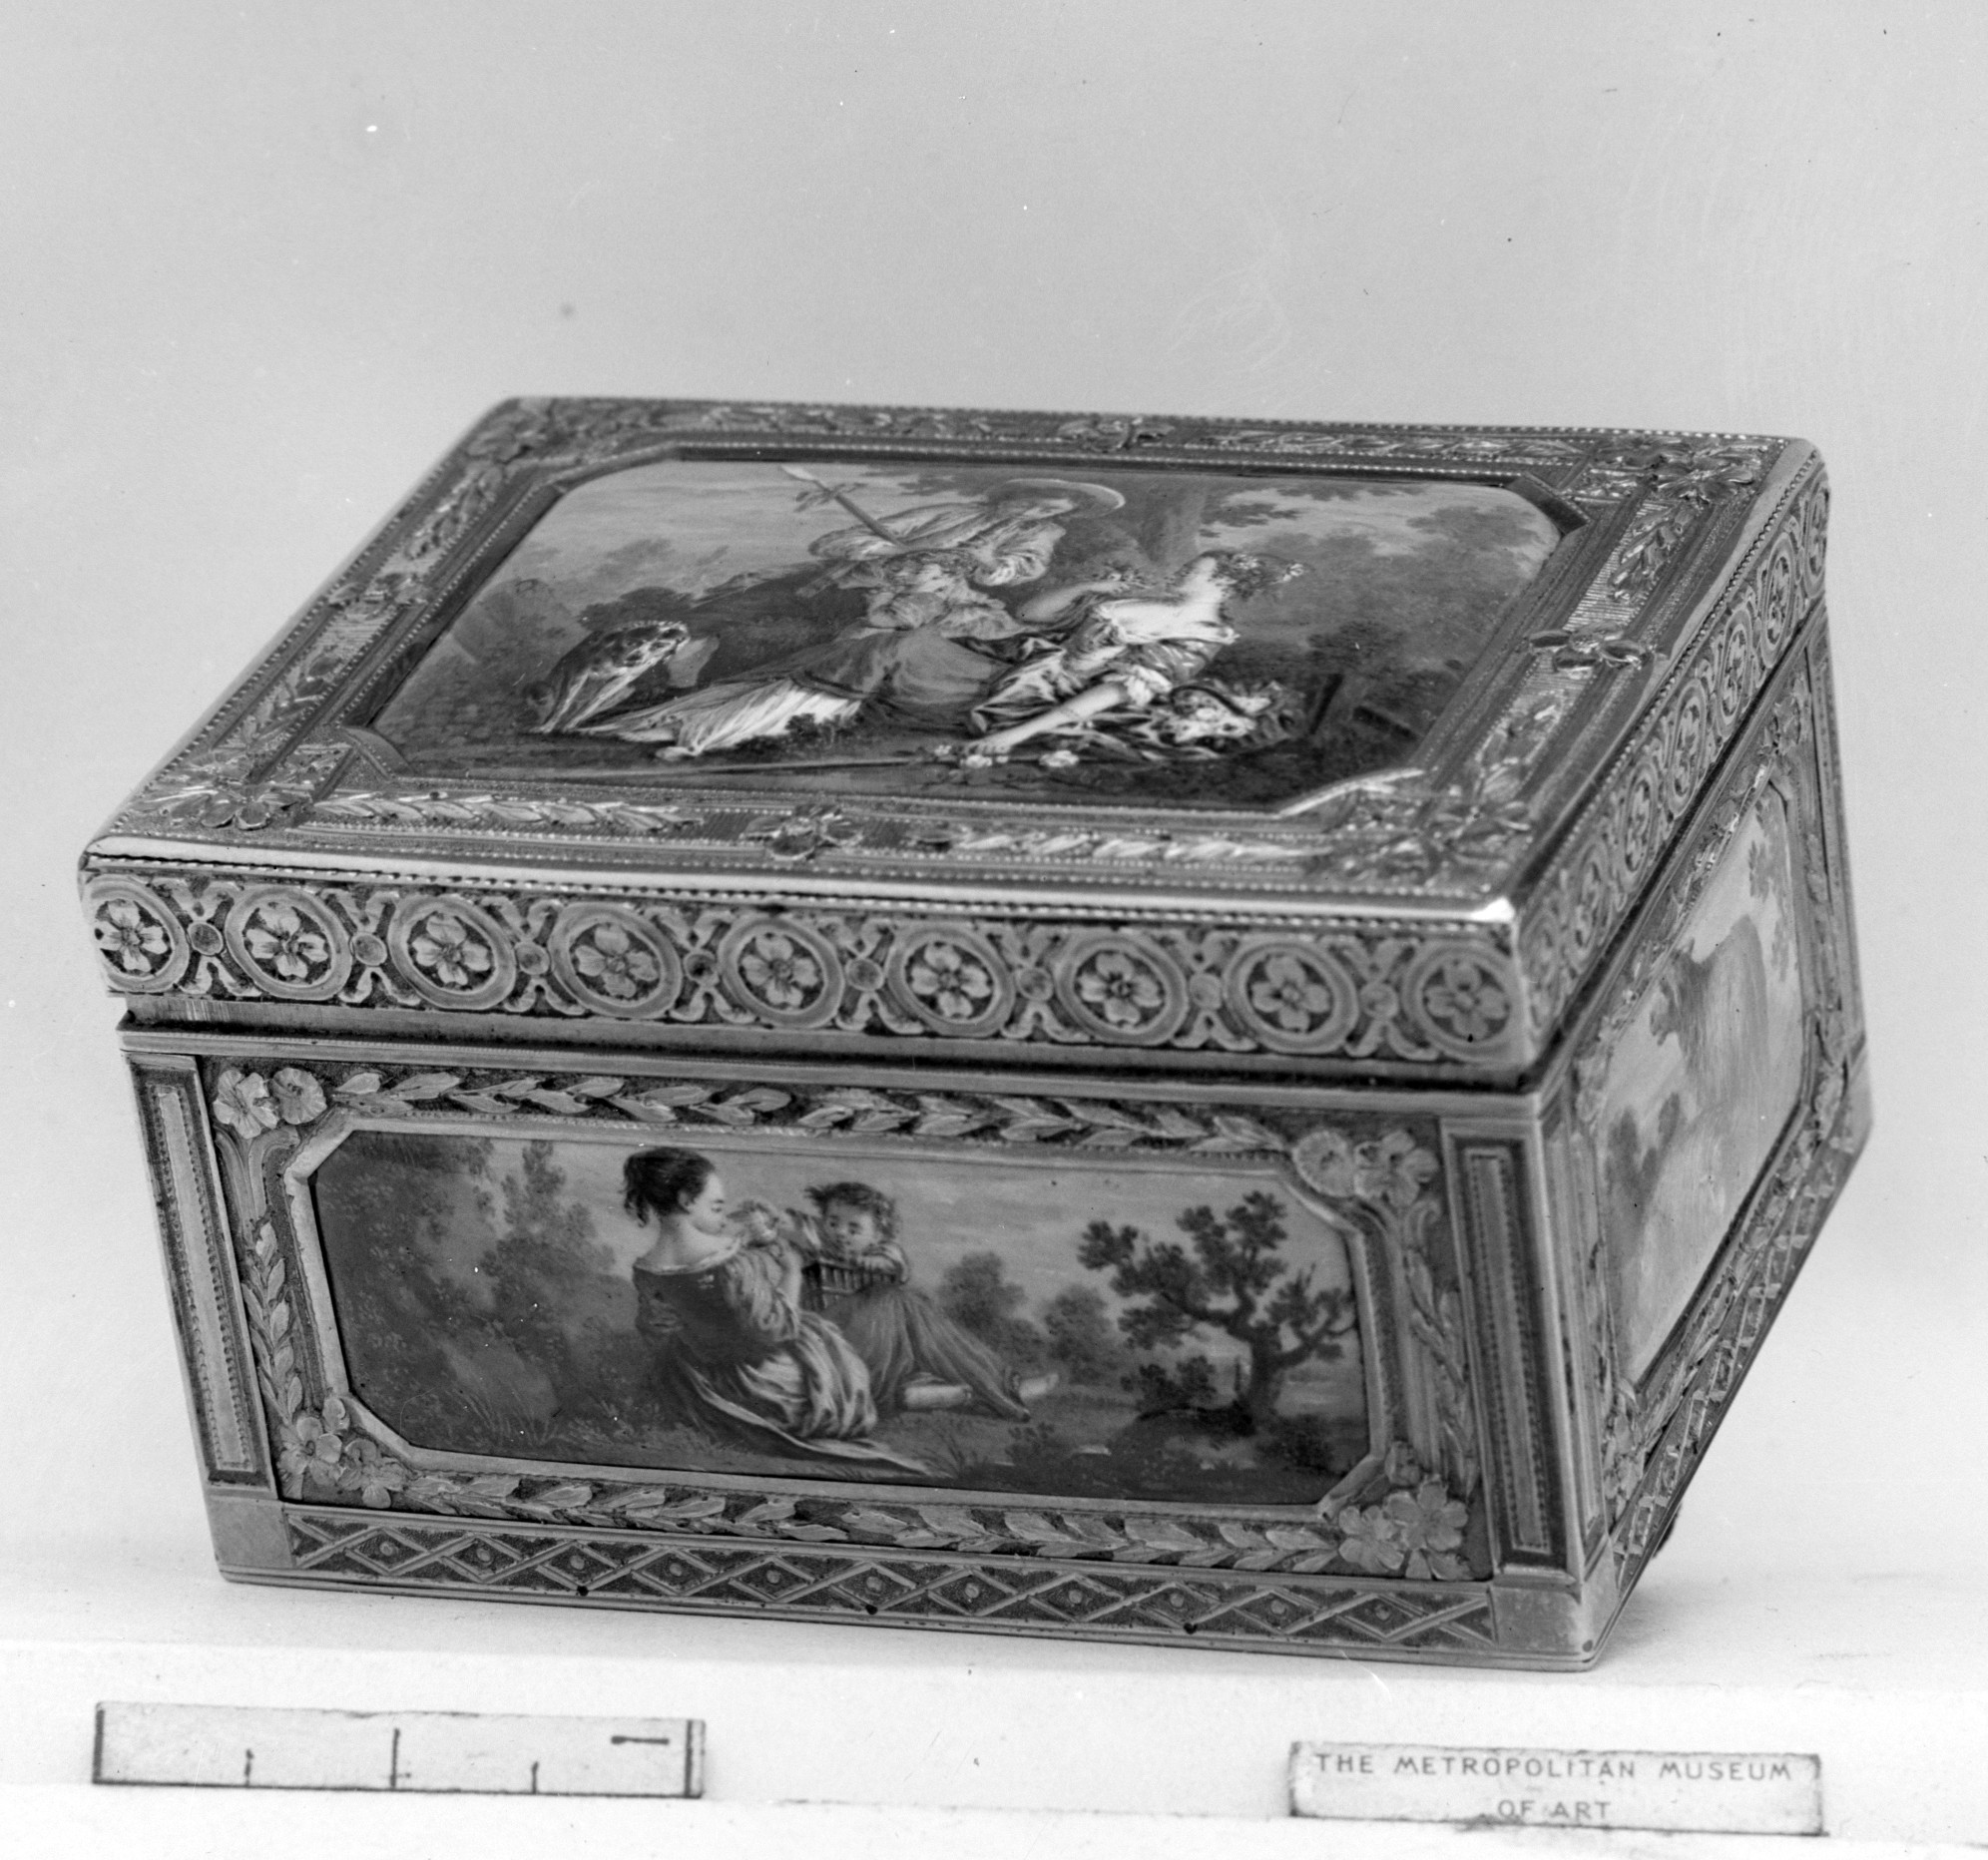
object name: snuffbox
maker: jean marie tiron (called tiron de nanteuil)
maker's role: maker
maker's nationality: french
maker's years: 1748-1793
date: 1762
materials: enamel, gold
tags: animals,children,women